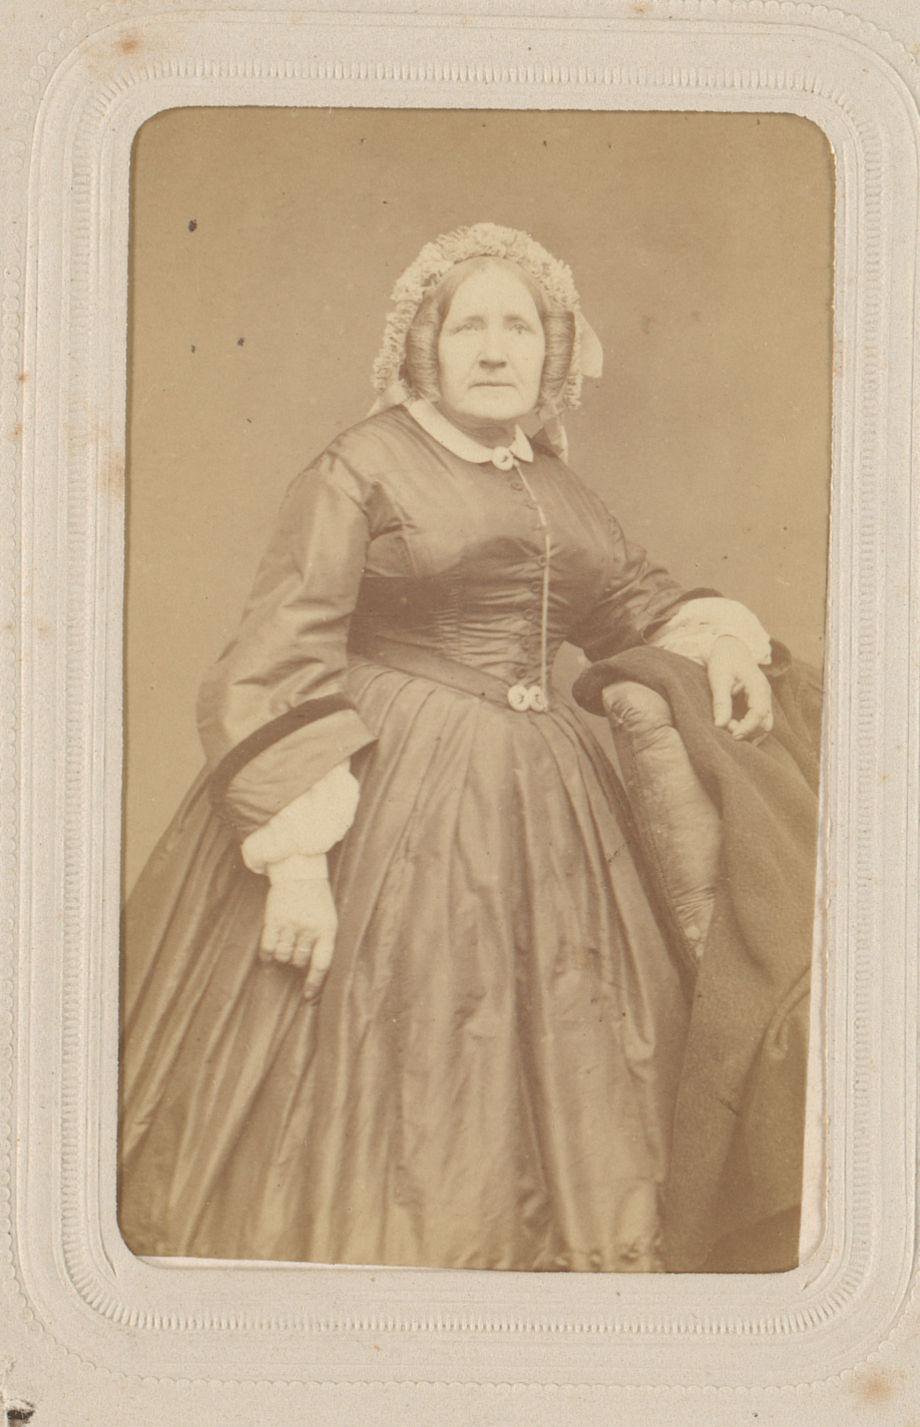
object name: carte de visite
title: Portret van een vrouw met muts, staand bij een stoel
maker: j. meurisse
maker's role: fotograaf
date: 1860-1900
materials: cardboard, photographic support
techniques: albumen print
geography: boulogne-sur-mer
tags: historical persons - bb - woman, head-gear: cap, standing figure - aa - female human figure, chair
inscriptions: inscription: ‘J. MEURISSE/ PHOTOG. DE S.M. L'EMPEREUR/ 36bis Rue Napoléon/ BOULOGNE S/MER’